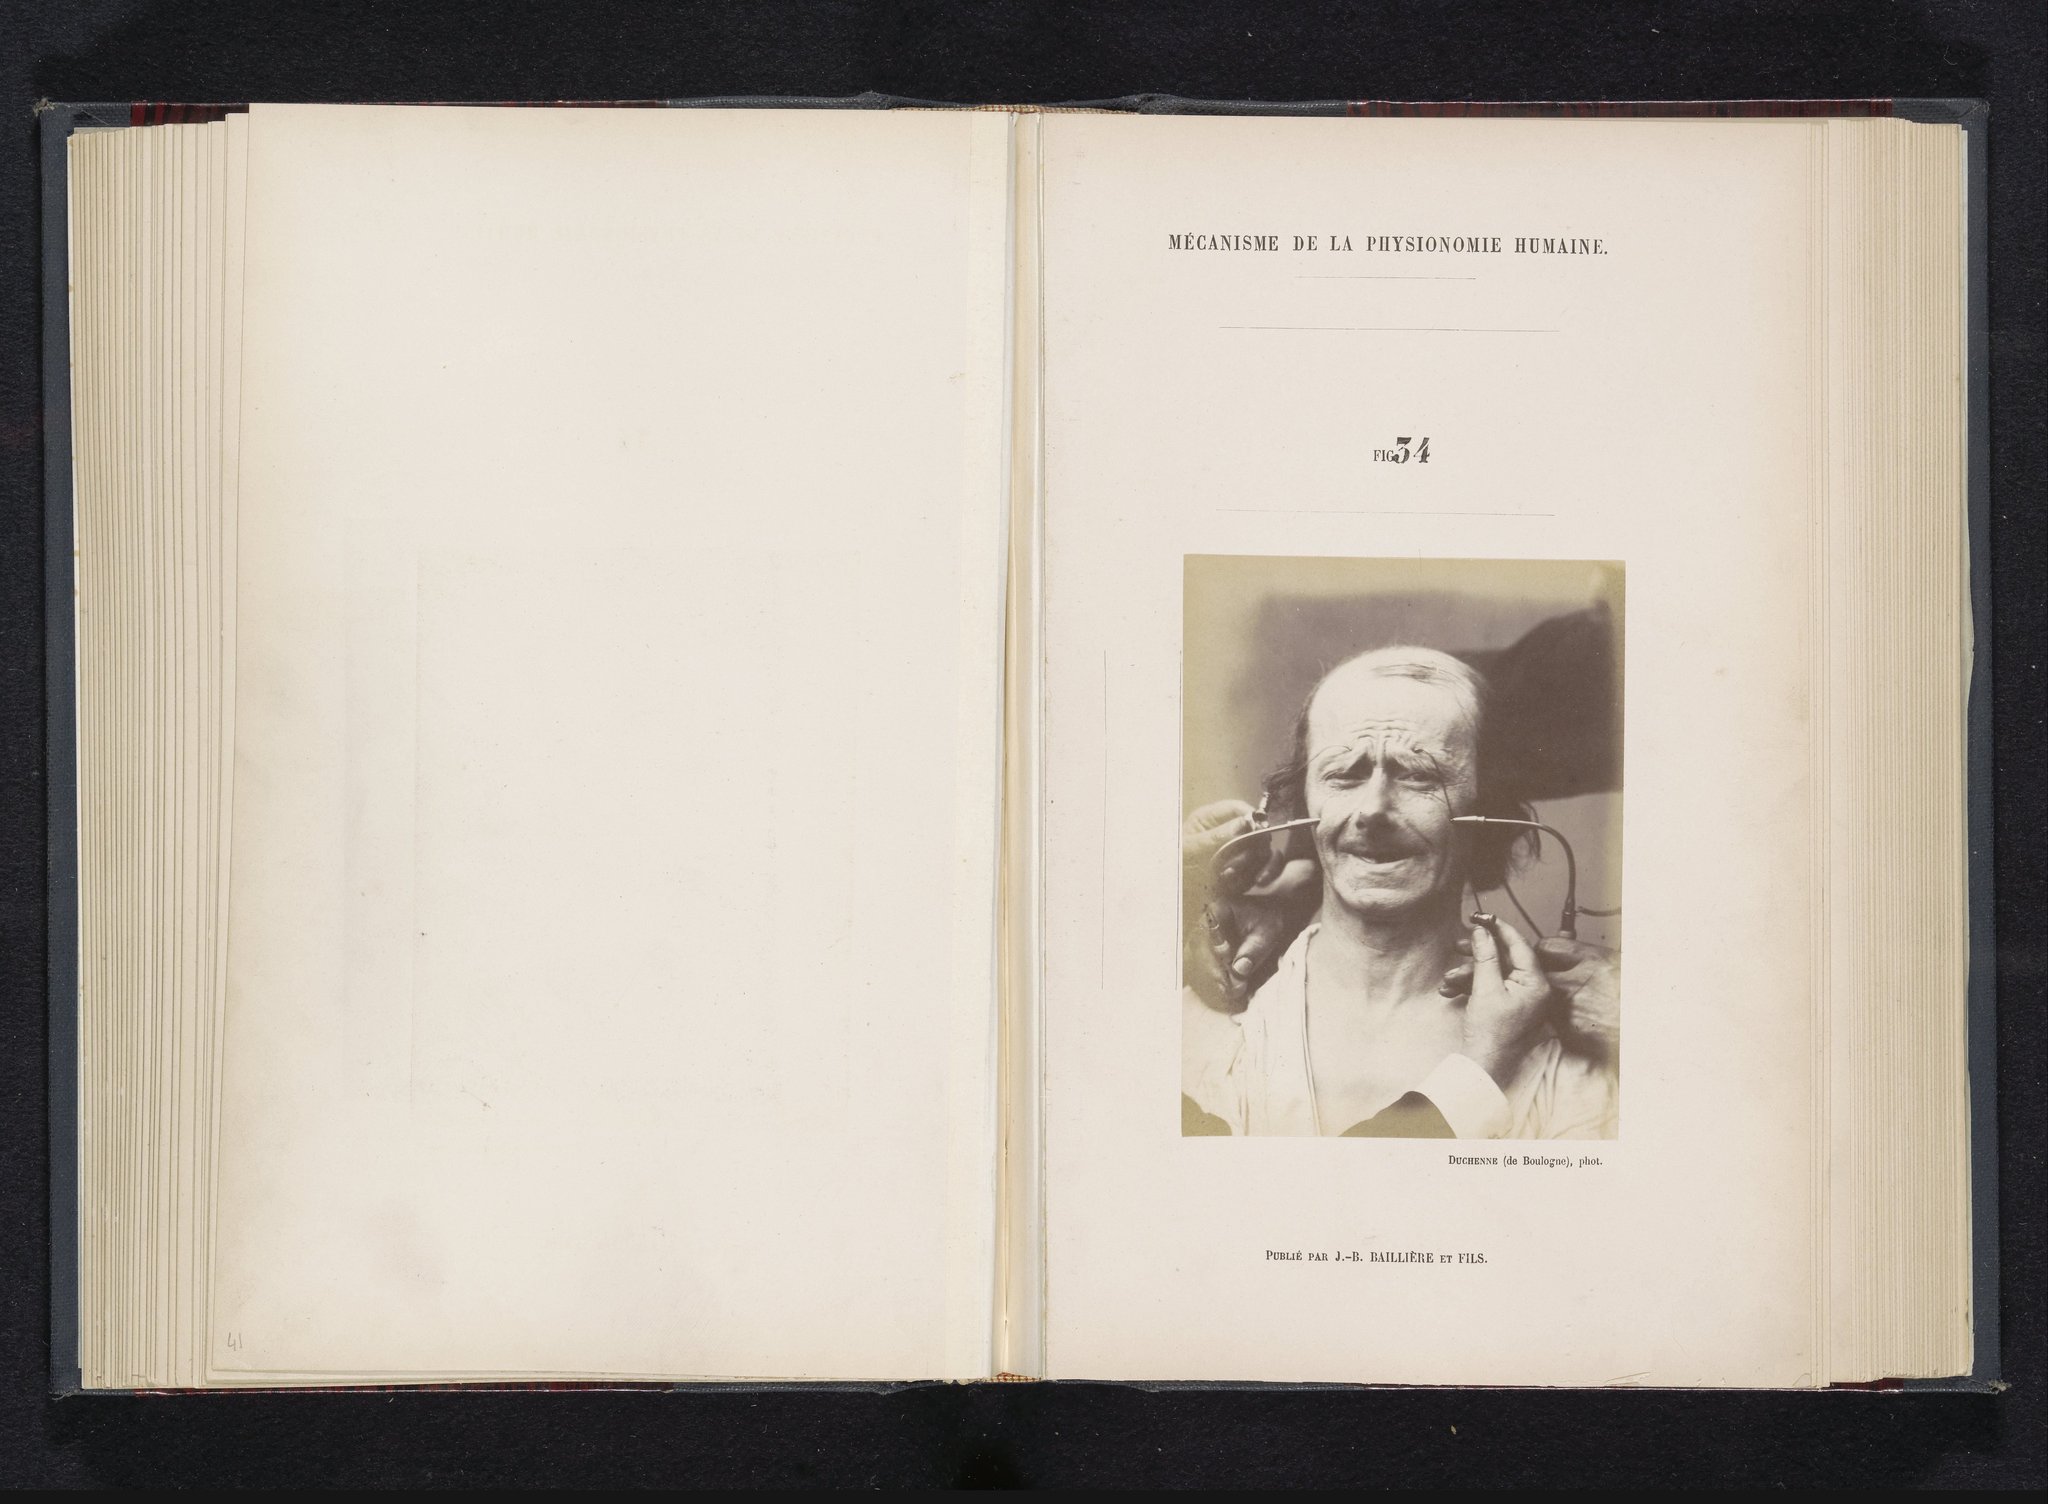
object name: photograph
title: Portret van een proefpersoon tijdens elektrostimulatie: 'un vieillard'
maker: guillaume benjamin amand duchenne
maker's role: fotograaf, medicus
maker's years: 1806-1875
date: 1860-1862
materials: paper, photographic support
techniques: albumen print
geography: paris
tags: face, physiology and anatomy ~ nervous system, neurology, physiology and anatomy, old man, morphology of facial expression, physiognomy, experiment, test ~ science and technology, france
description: Ongenummerde pagina met foto 34 uit Mécanisme de la physionomie humaine ou analyse électro-physiologique de l'expression des passions (Atlas).